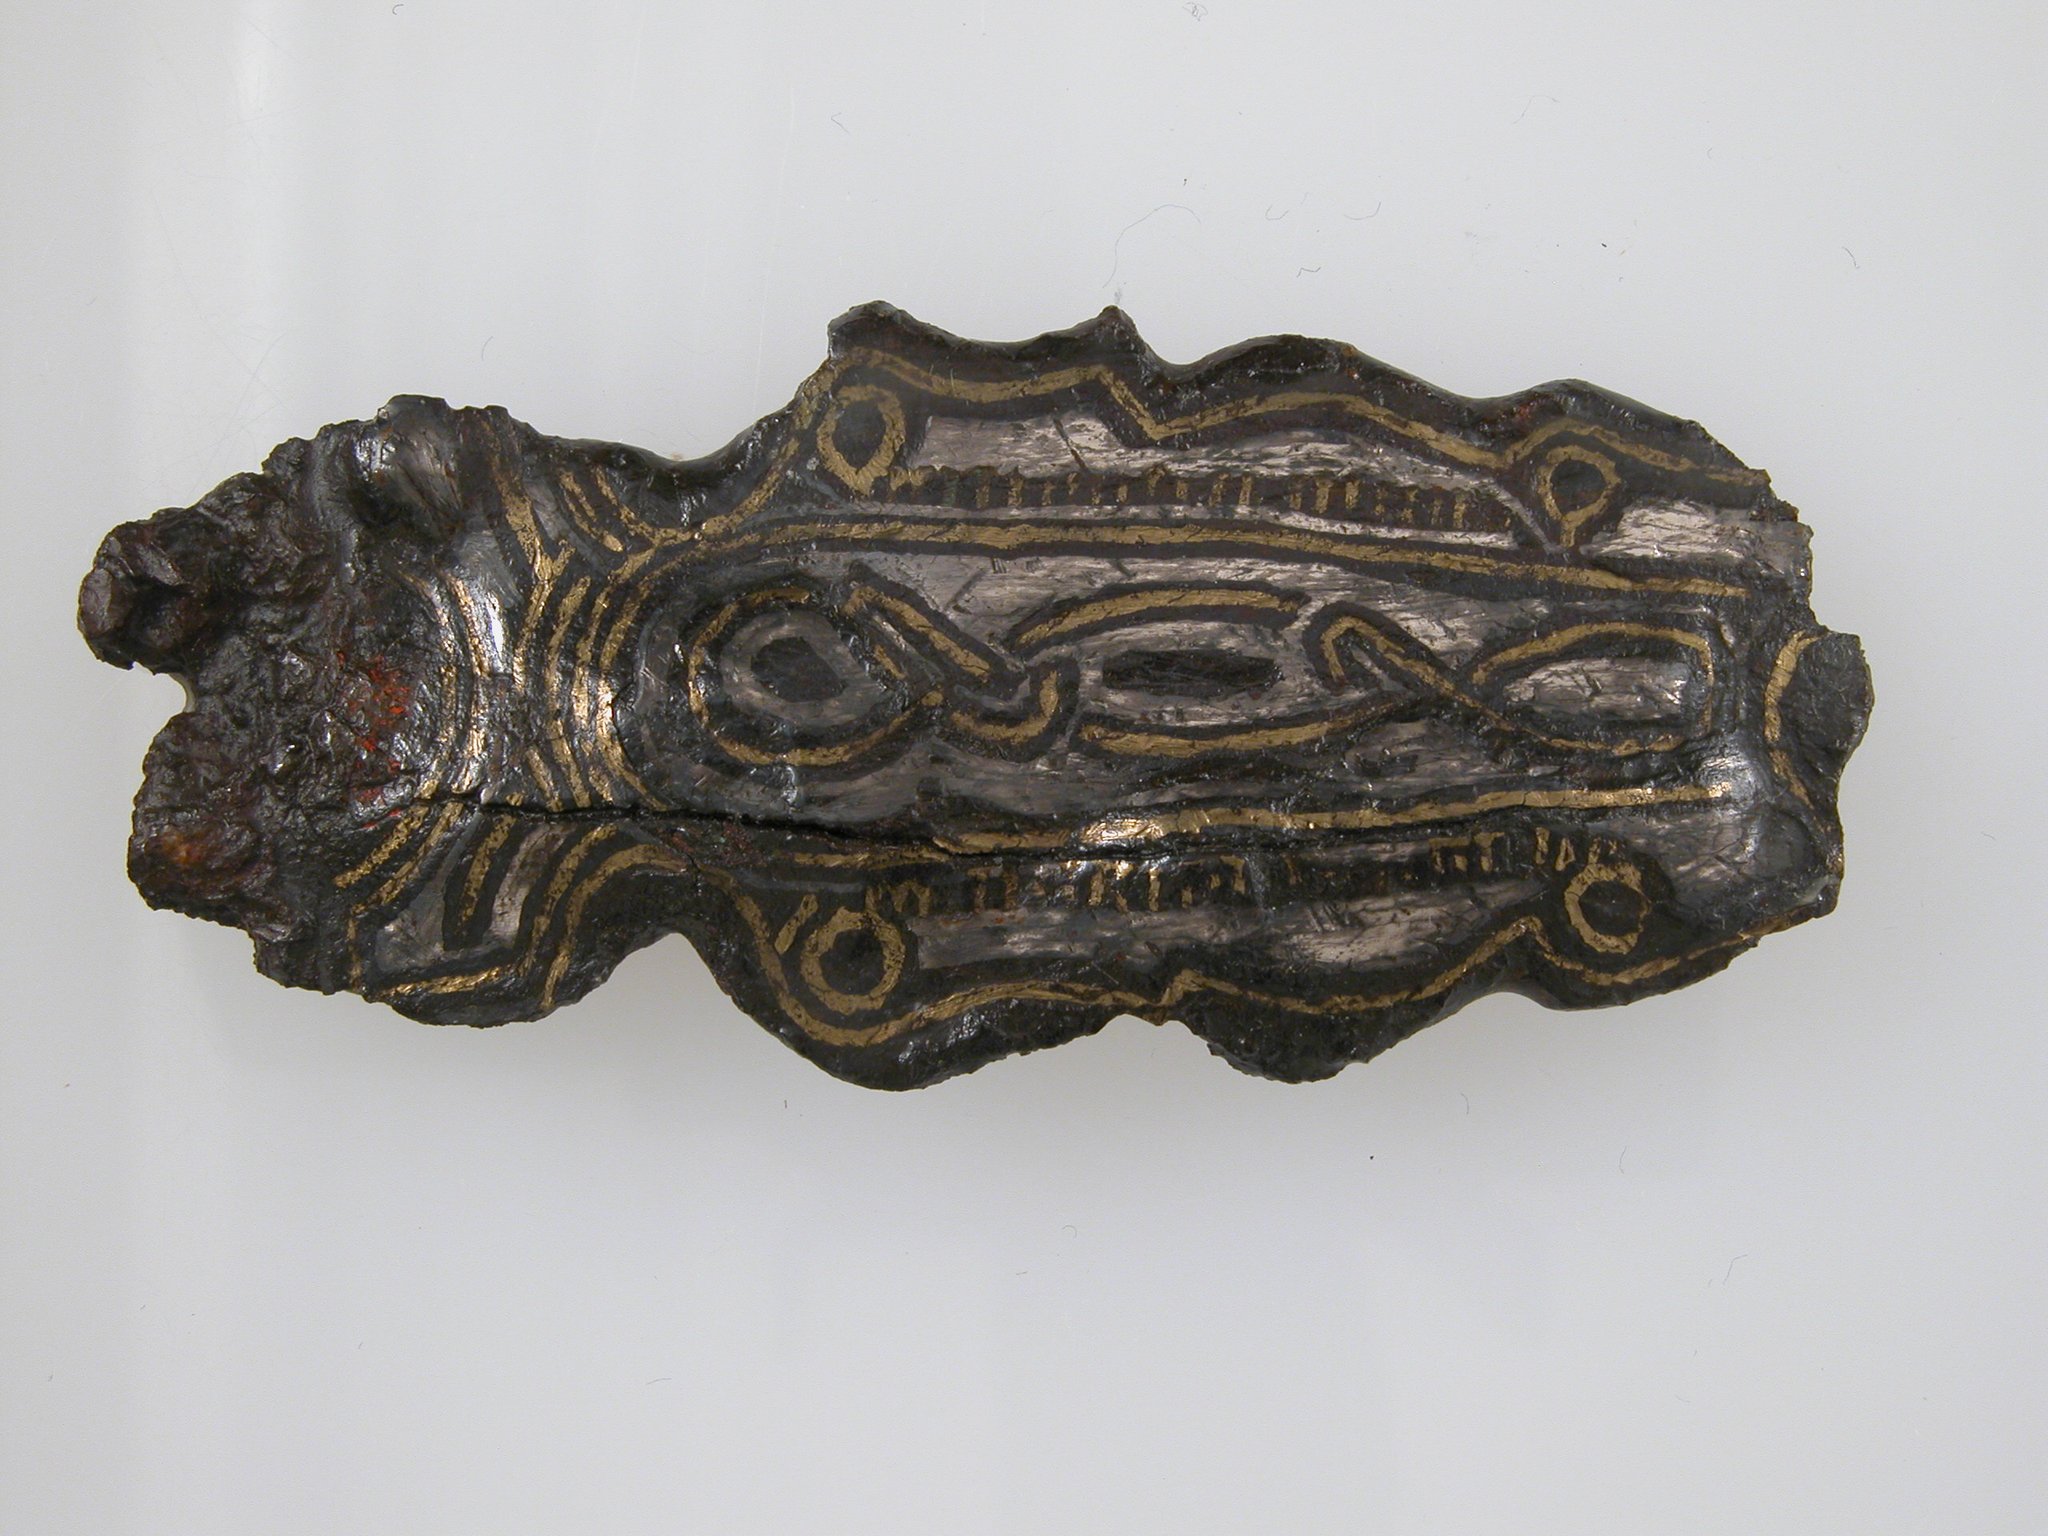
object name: fragment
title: Belt Plate Fragment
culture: frankish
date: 500-700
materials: brass, iron, silver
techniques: inlay